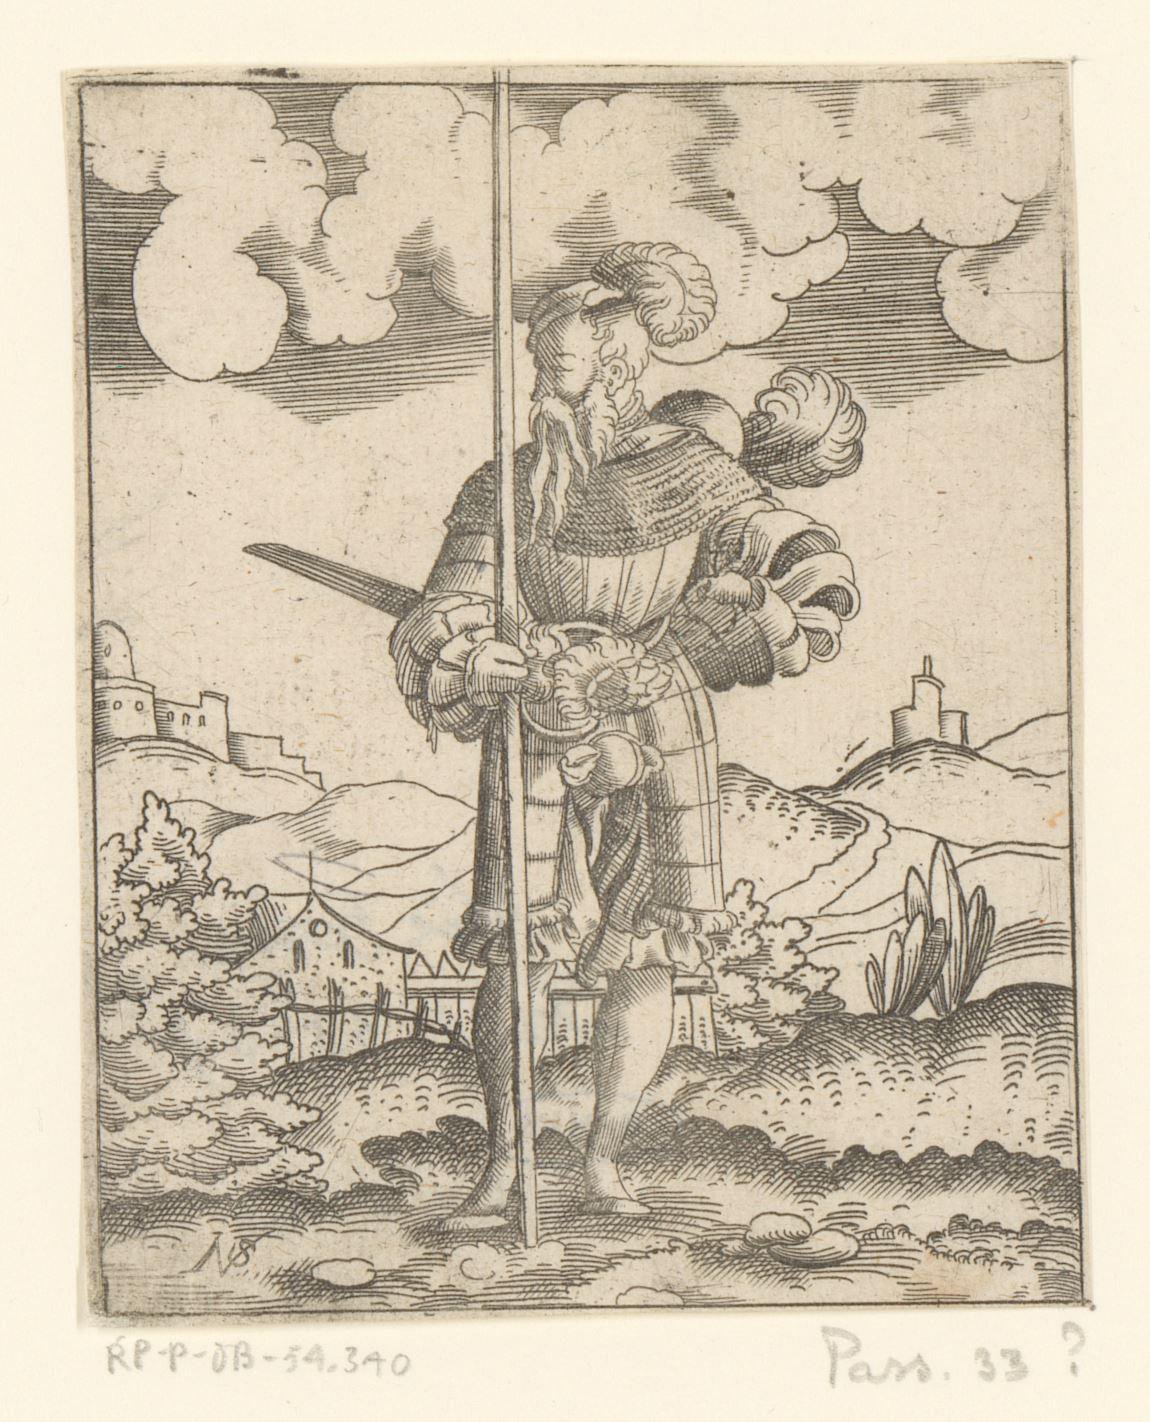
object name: print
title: Soldaat met een lans in zijn rechterhand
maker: nikolaus solis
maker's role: print maker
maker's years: 1542-1584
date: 1552-1584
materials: paper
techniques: etching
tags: city-view, and landscape with man-made constructions, helved weapons, polearms (for striking, hacking, thrusting): pike, the soldier; the soldier's life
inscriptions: collector's mark: Lugt 2228